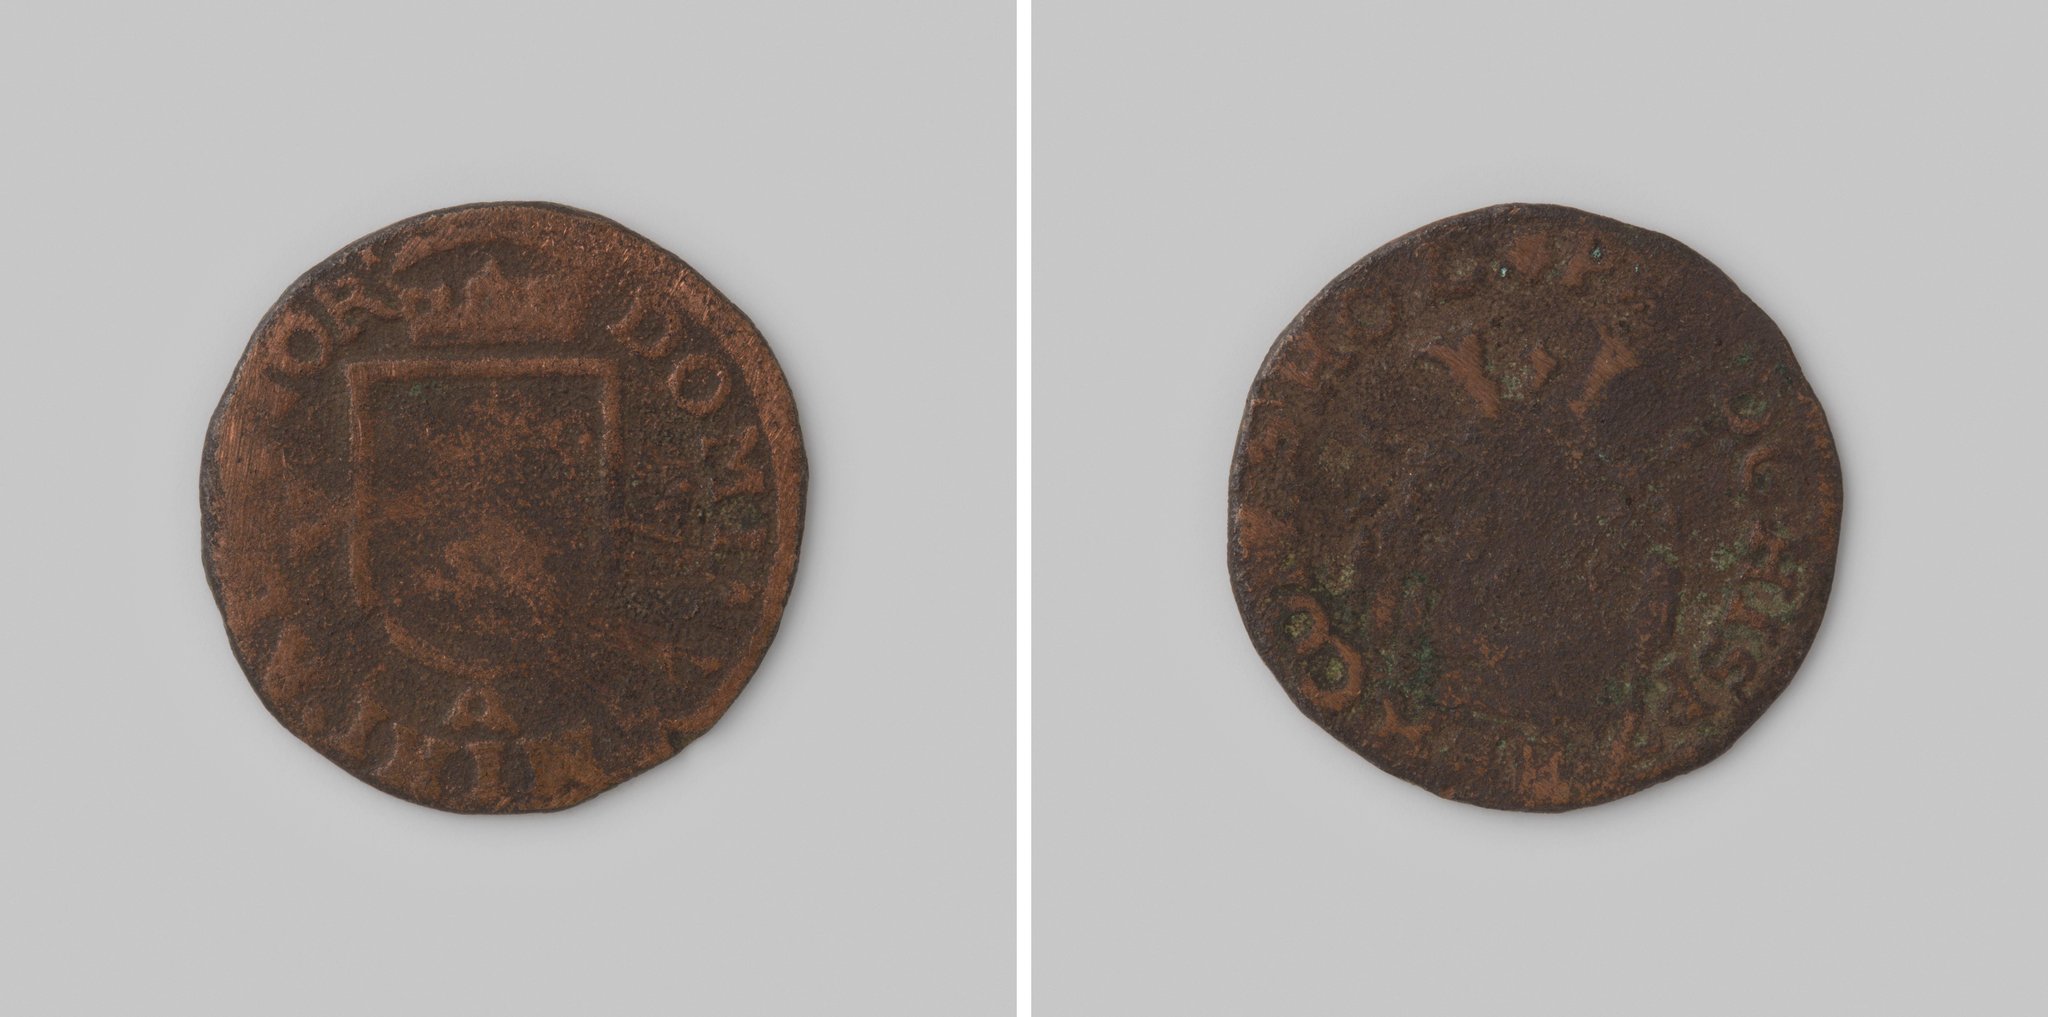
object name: coin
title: Hollandse duit op naam van Philips II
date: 1573-1579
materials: copper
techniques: striking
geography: dordrecht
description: Koperen munt. Voorzijde: gekroond wapenschild van Holland op stokkenkruis. In omschrift naam van Philips II. Keerzijde: Stokkenkruis met vonken binnen omheining.